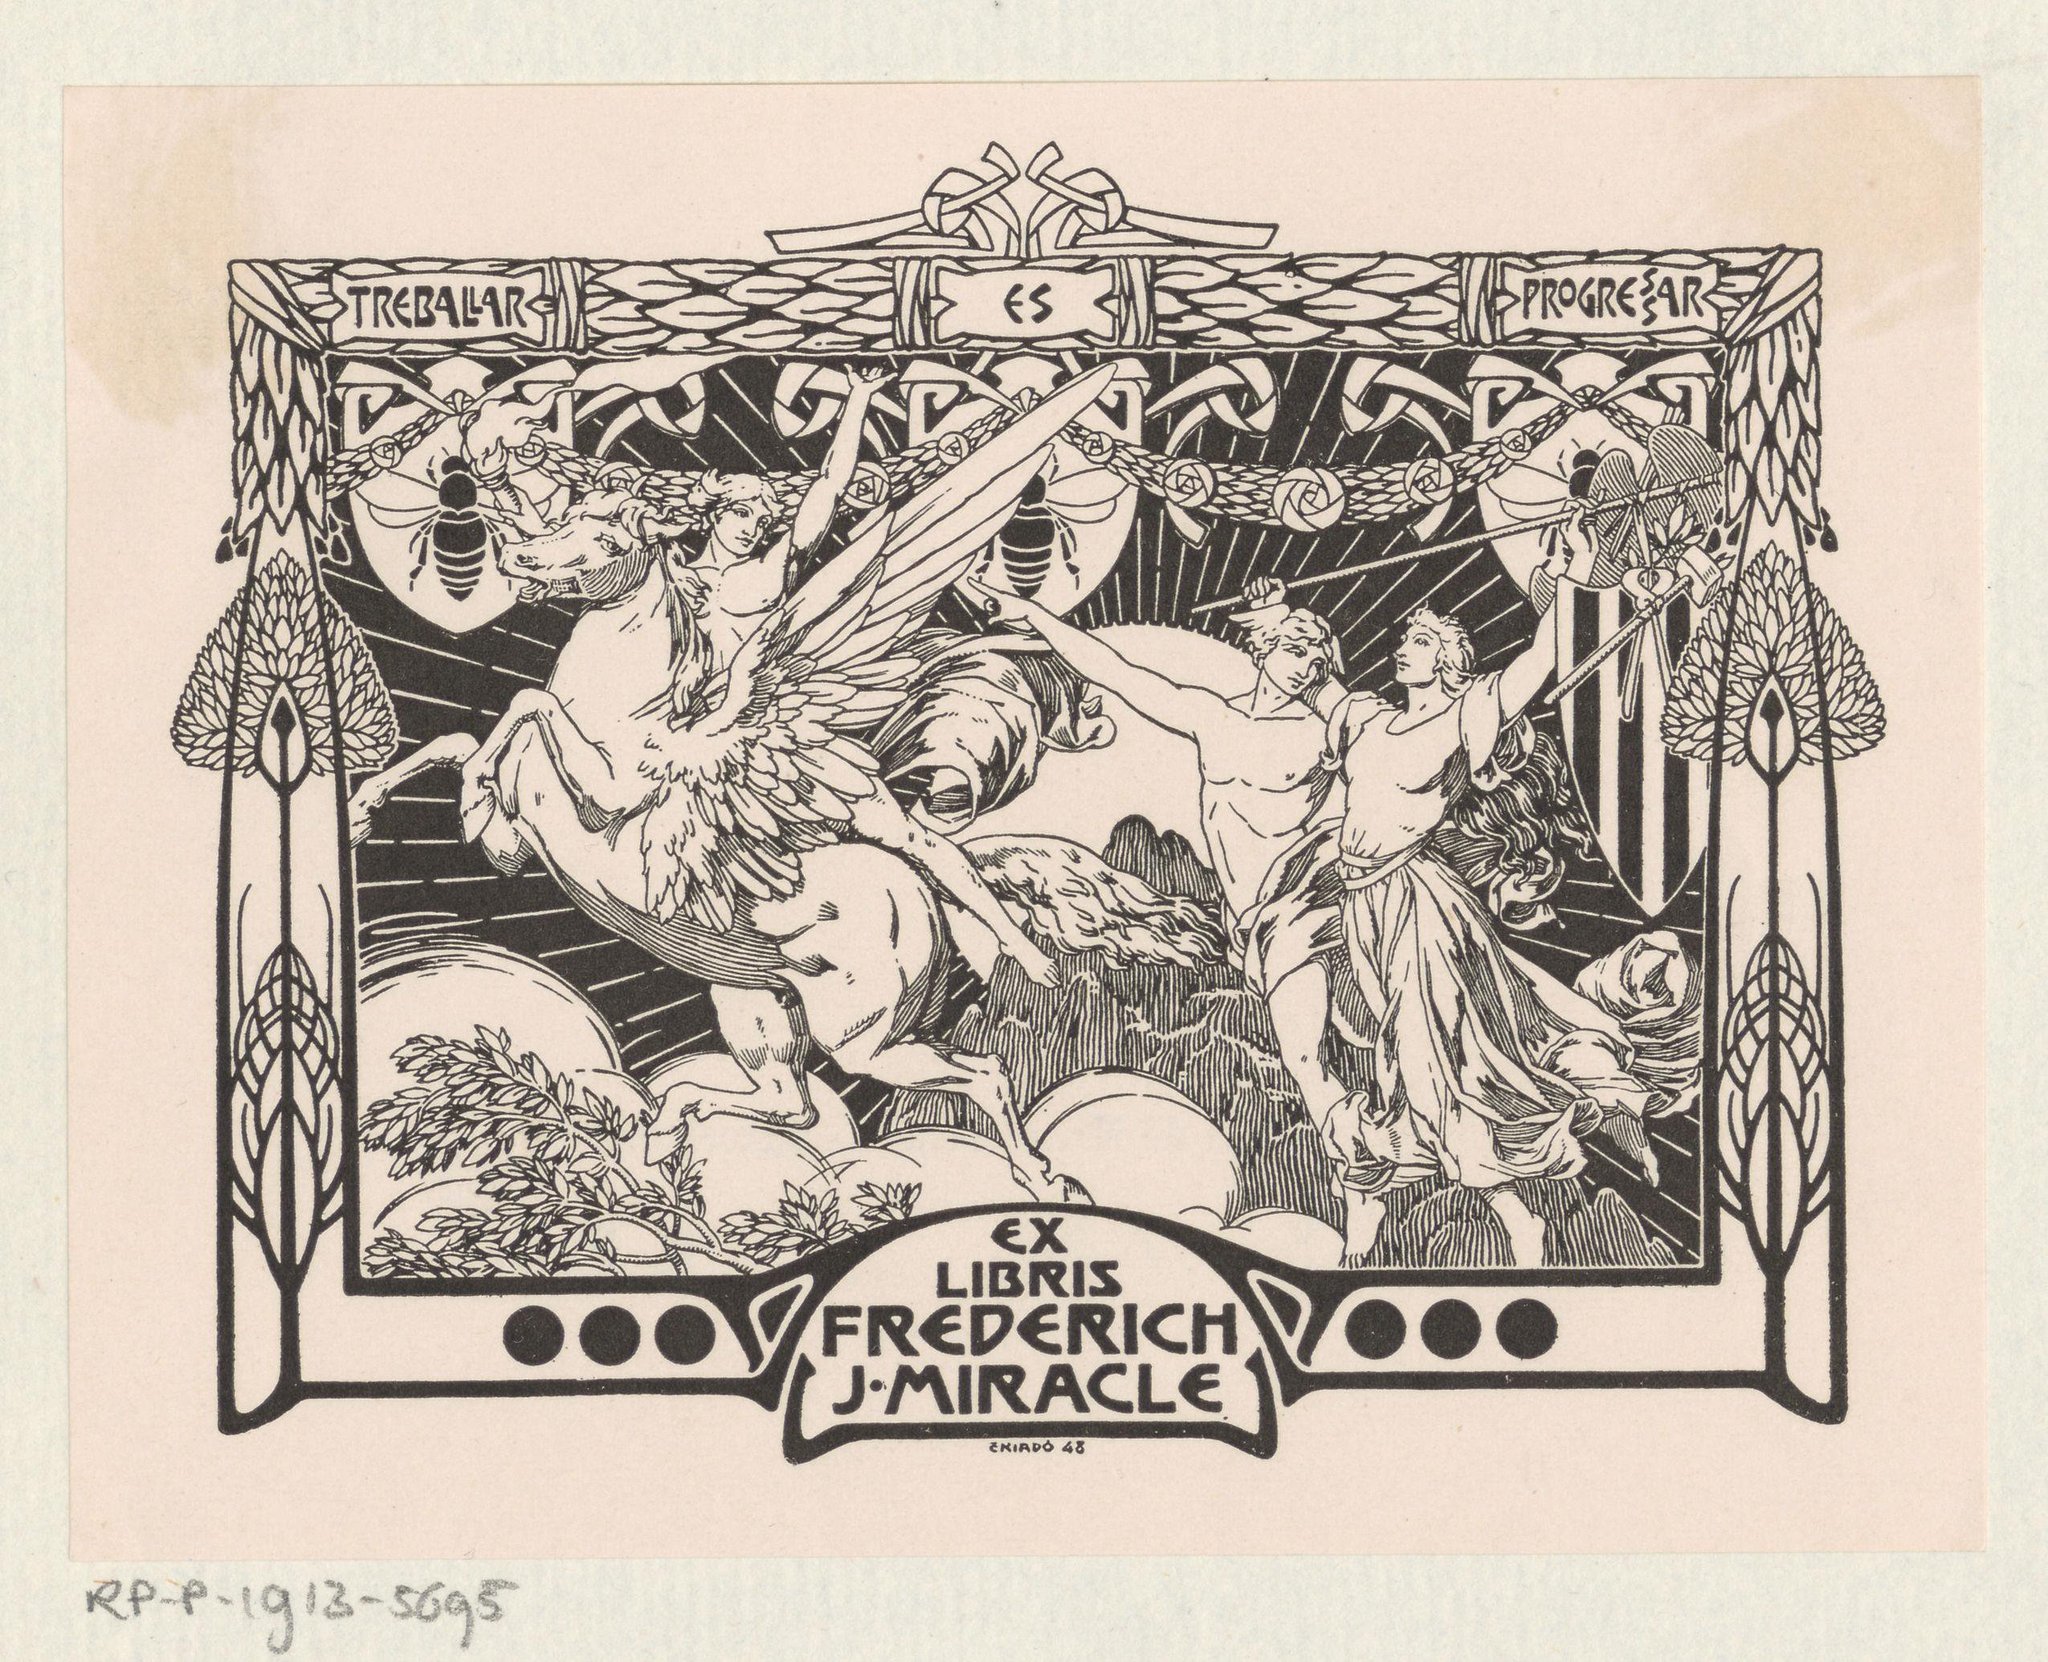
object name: bookplate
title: Treballar es progressar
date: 1880-1913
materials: paper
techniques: printing block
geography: barcelona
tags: flowers ~ ornament - aa - stylized, (story of) mercury (hermes), sun as celestial body, (story of) cupid, amor (eros)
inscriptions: collector's mark: Lugt 2760, collector's mark: Lugt 2233, workshop stamp: ‘Dessin de Mr. J. Triado - Barcelona’